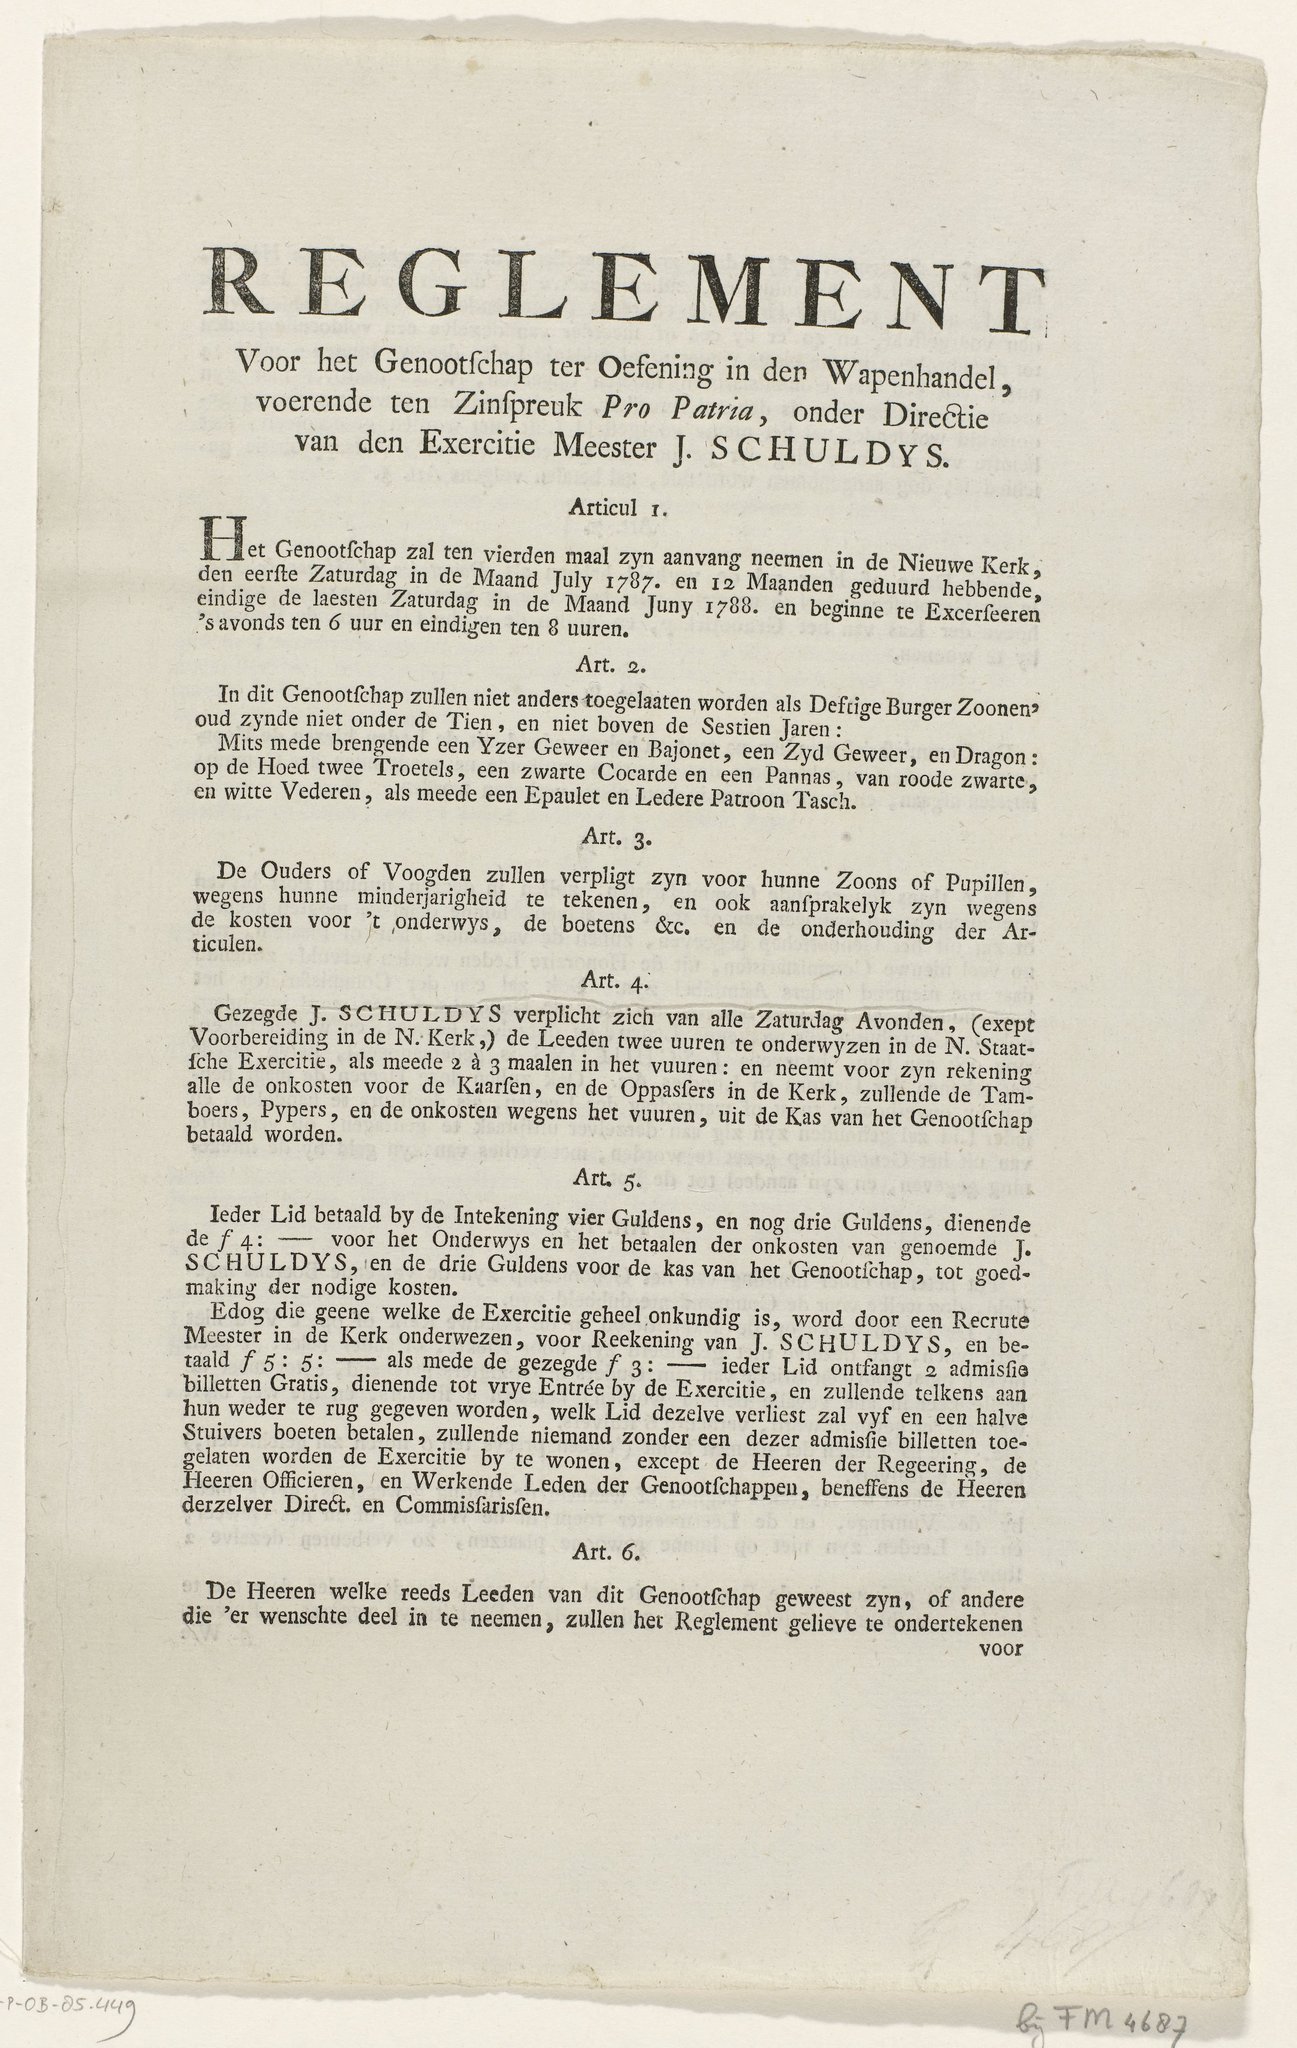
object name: text sheet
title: Reglement van het Genootschap Pro Patria, 1787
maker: Anonymous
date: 1787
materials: paper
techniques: letterpress printing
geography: amsterdam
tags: genootschap pro patria, nieuwe kerk, oprichting exercitiegenootschappen (1783-1786)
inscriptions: collector's mark: Lugt 2228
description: Tekstblad met het reglement van het Genootschap ter Oefening van de Wapenhandel Pro Patria te Amsterdam. Dubbelgevouwen blad bedrukt op drie bladzijden met de 13 artikelen van het reglement van het genootschap opgesteld op 1 juli 1787 door de exercitie meester J. Schuldijs.